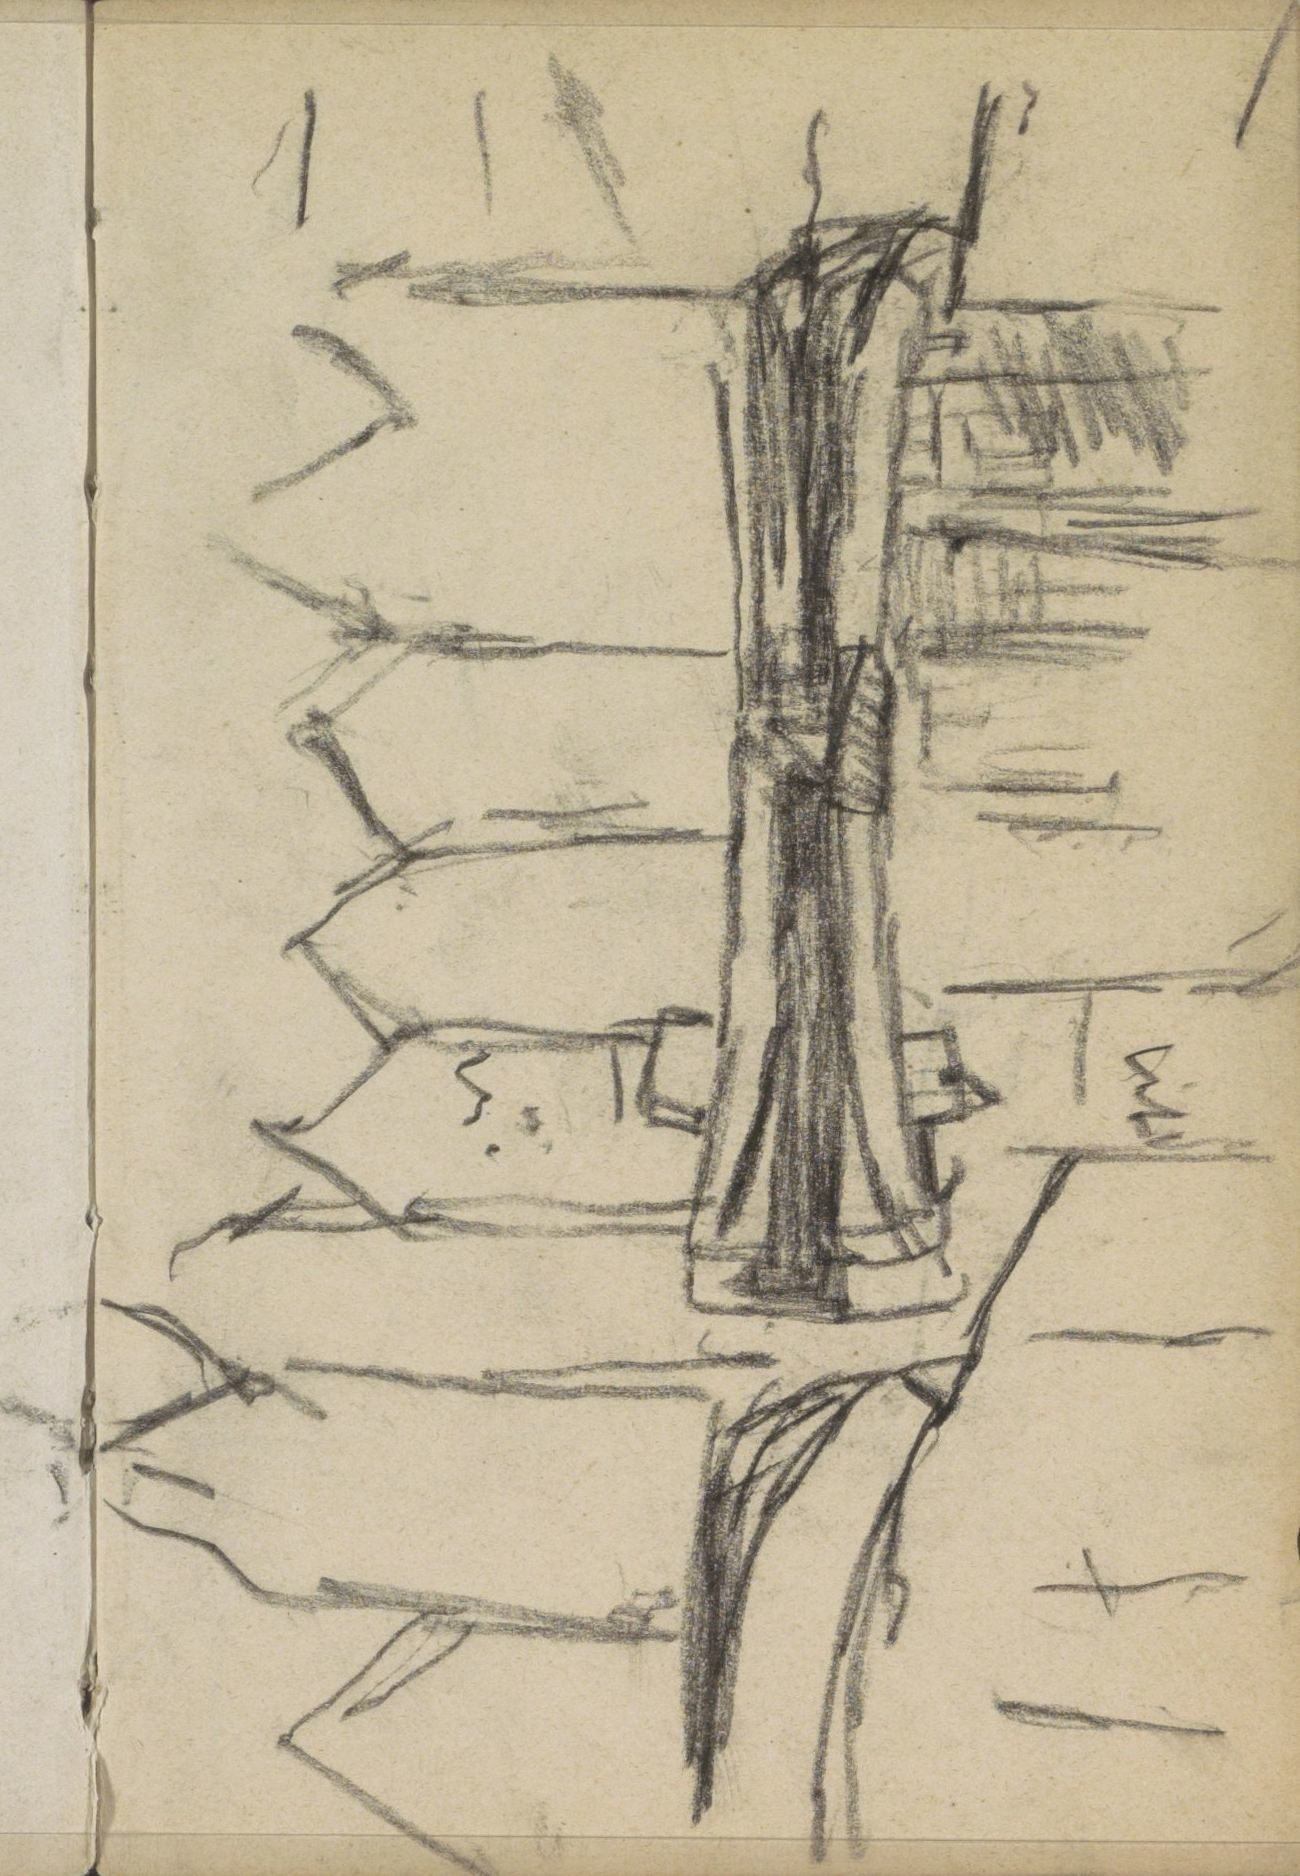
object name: sketchbook leaf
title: Gezicht op Prinseneiland te Amsterdam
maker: george hendrik breitner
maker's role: draughtsman, painter, print maker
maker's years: 1857-1923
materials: chalk, paper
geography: amsterdam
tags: civic architecture; edifices; dwellings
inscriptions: kleurnotitie, handgeschreven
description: Pagina 74 uit een schetsboek met 46 bladen.